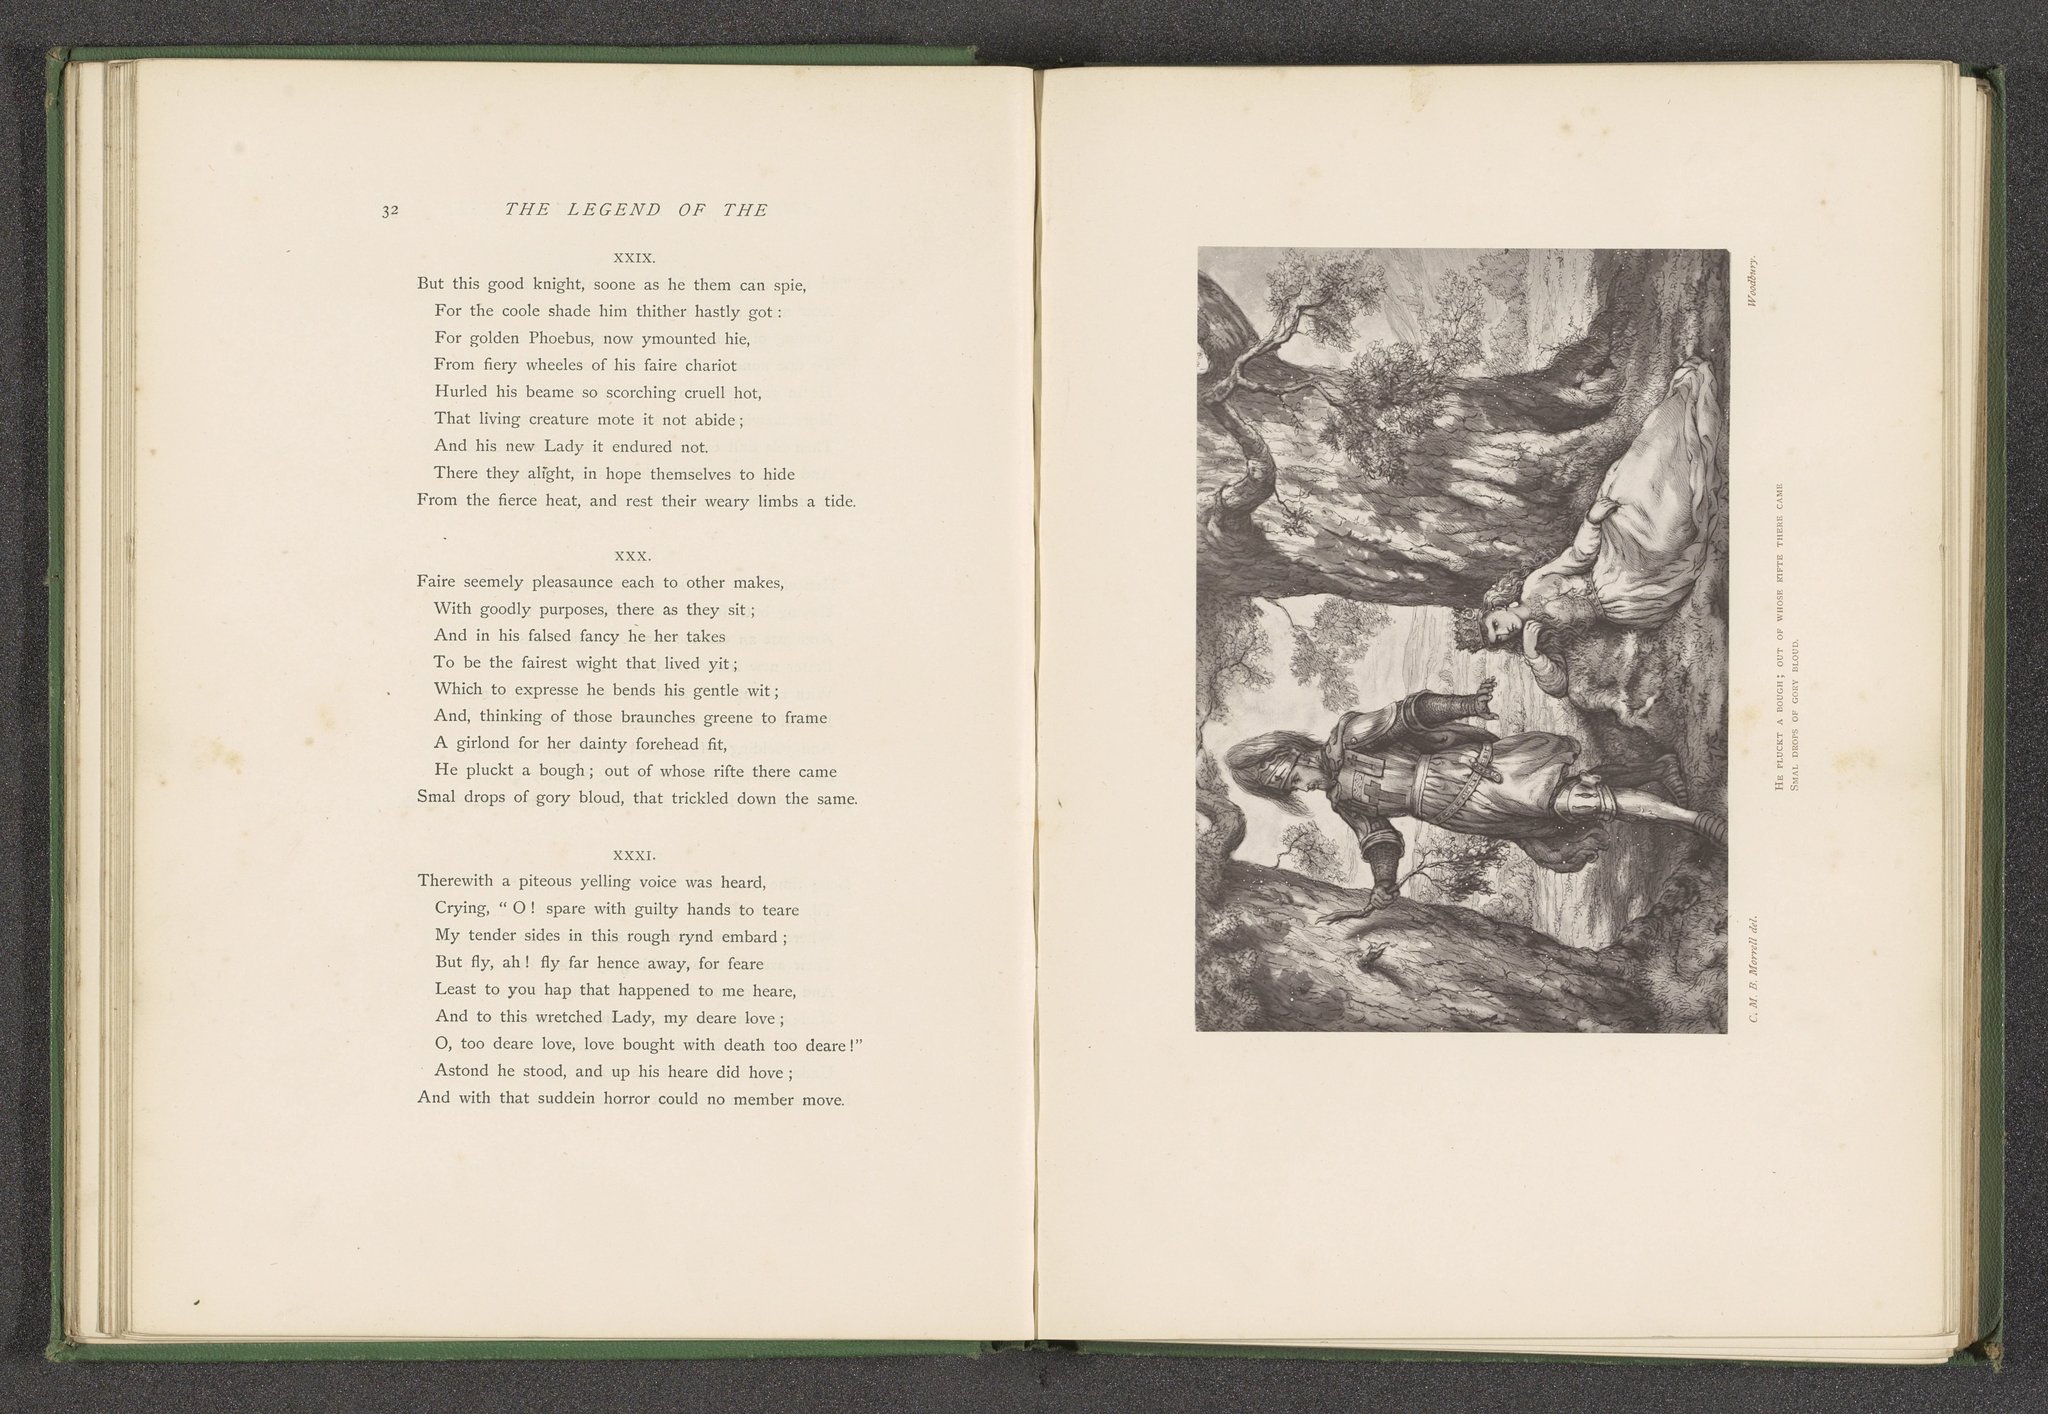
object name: page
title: Fotoreproductie van een tekening, voorstellende Redcrosse en Duessa naast een bloedende boom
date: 1861-1871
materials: paper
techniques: woodburytype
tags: lying figure - aa - female human figure, knight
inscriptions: inscription: ‘He pluckt (...) of gory bloud.’